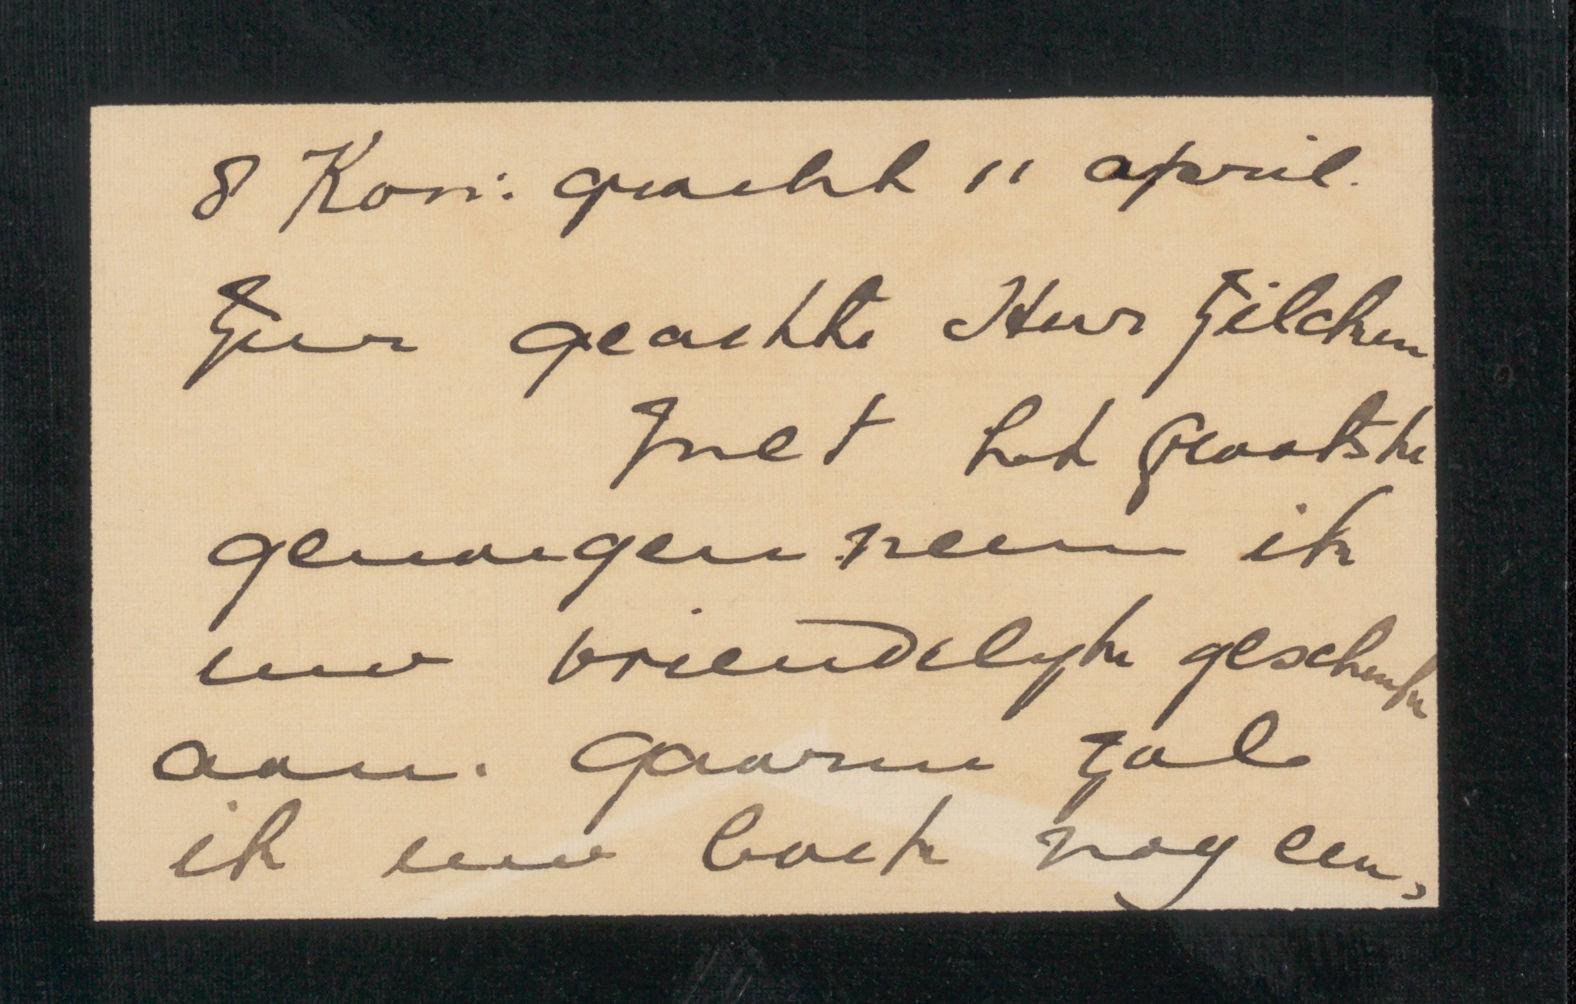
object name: letter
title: Brief aan Philip Zilcken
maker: eugénie loudon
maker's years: 1861-1940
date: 1916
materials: cardboard, ink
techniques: pen, writing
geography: the hague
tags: the hague, painter, philip zilcken, printed matter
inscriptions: collector's mark: ‘RPK’